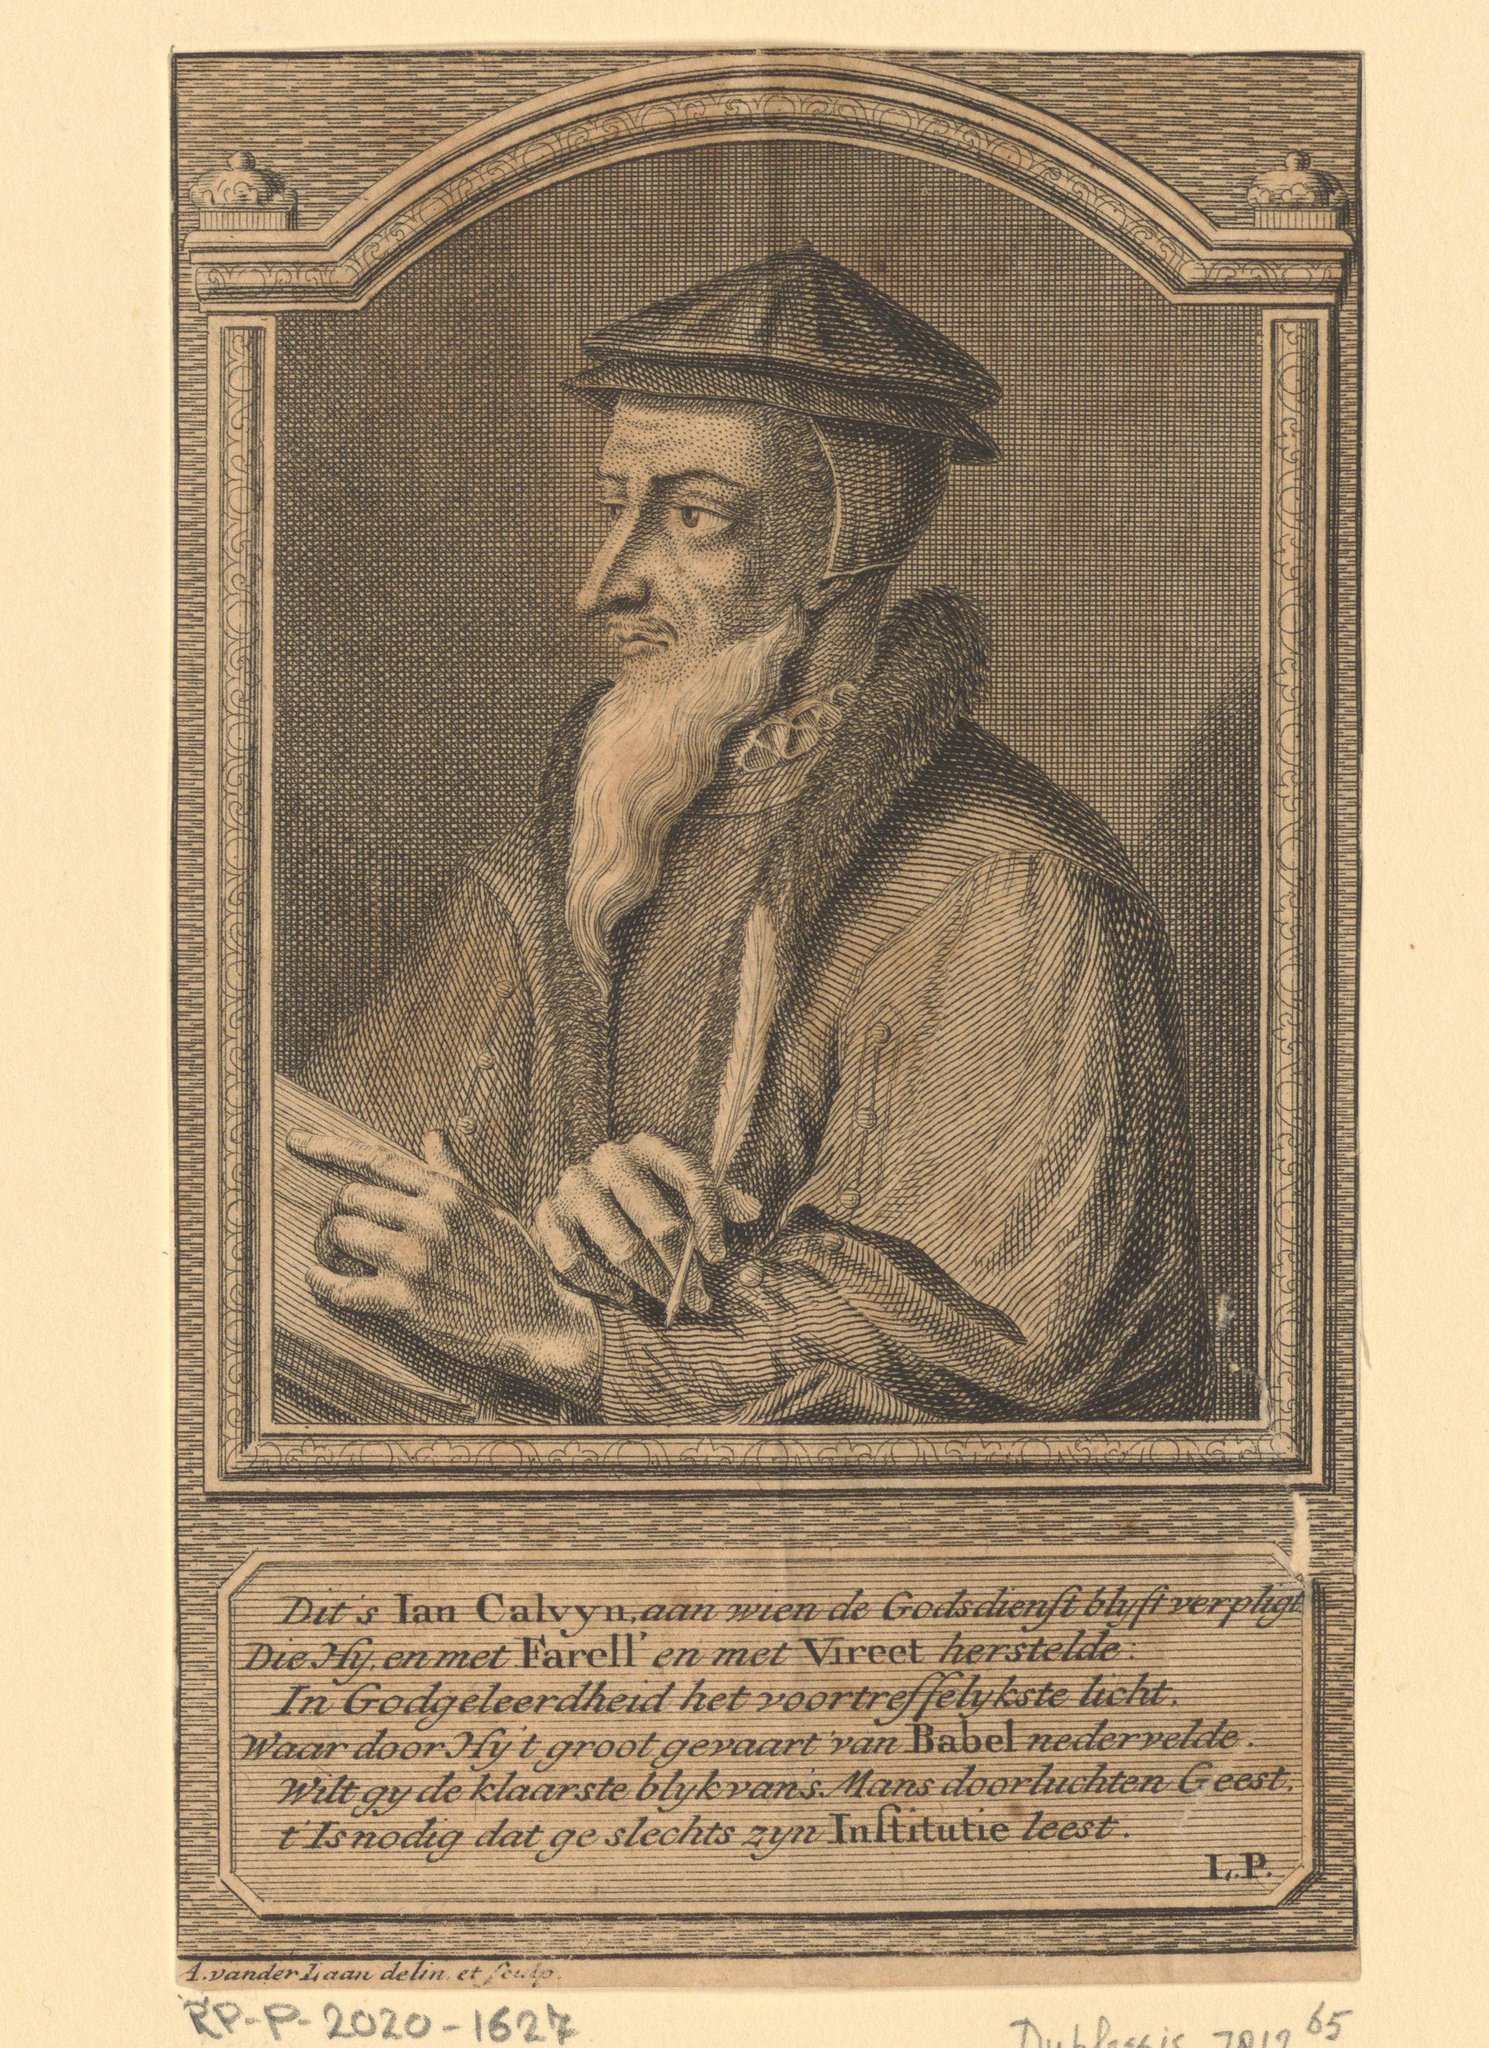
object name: print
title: Portret van Johannes Calvijn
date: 1755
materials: paper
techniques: engraving, etching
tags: historical persons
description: Prent mogelijk uit: Laan, Adolf van der. Afbeeldingen en levensbeschrijvingen van eenige voorname personen (...). Leeuwarden: Abraham Ferwerda, 1755.